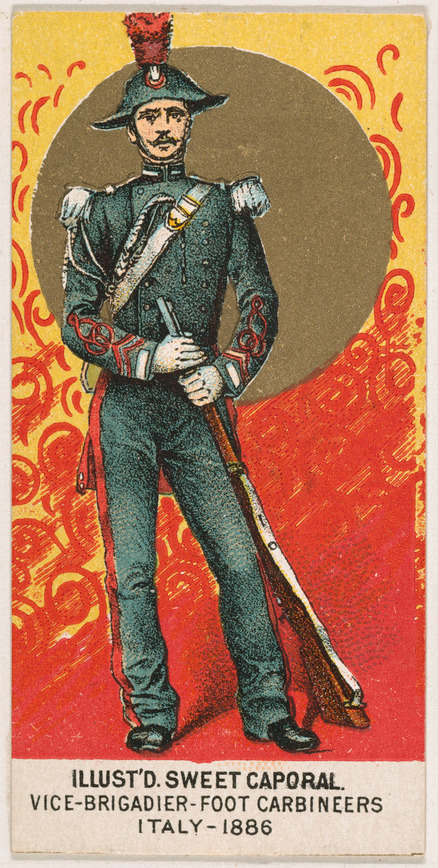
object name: print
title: Vice-Brigadier, Foot Carbineers, Italy, 1886, from the Military Series (N224) issued by Kinney Tobacco Company to promote Sweet Caporal Cigarettes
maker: kinney brothers tobacco company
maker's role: publisher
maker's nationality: american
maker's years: 1869-2011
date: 1888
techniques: color lithograph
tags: soldiers,firearms,men